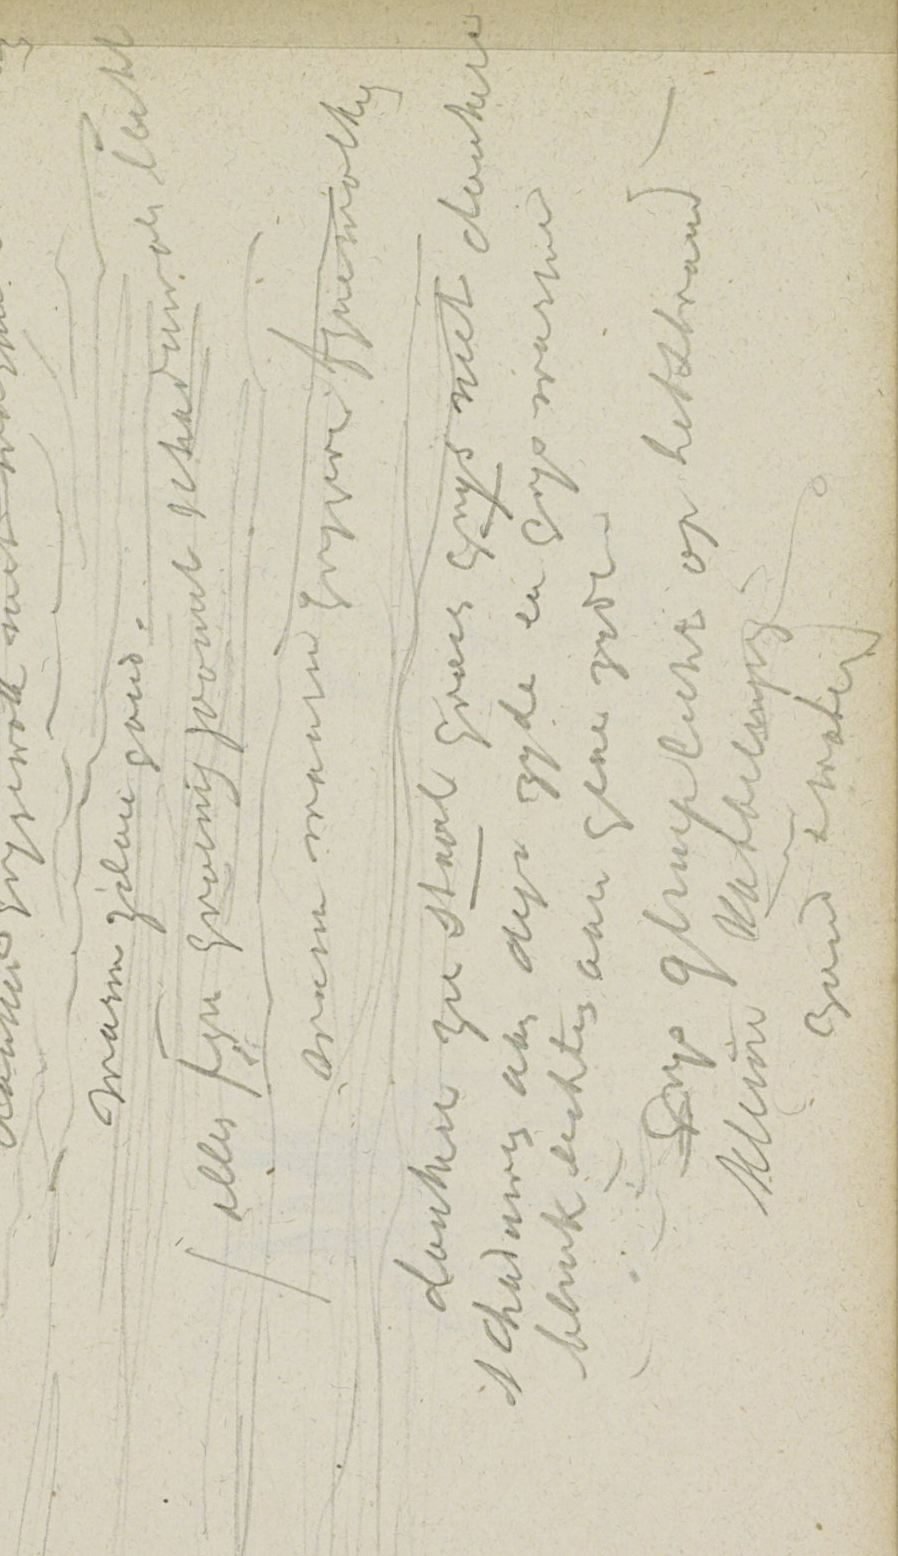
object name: sketchbook leaf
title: Zeegezicht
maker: johannes tavenraat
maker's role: draughtsman, painter, print maker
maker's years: 1809-1881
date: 1854-1868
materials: paper, pencil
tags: sea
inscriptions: kleurnotitie, handgeschreven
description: Blad 47 recto uit een schetsboek met 88 bladen.